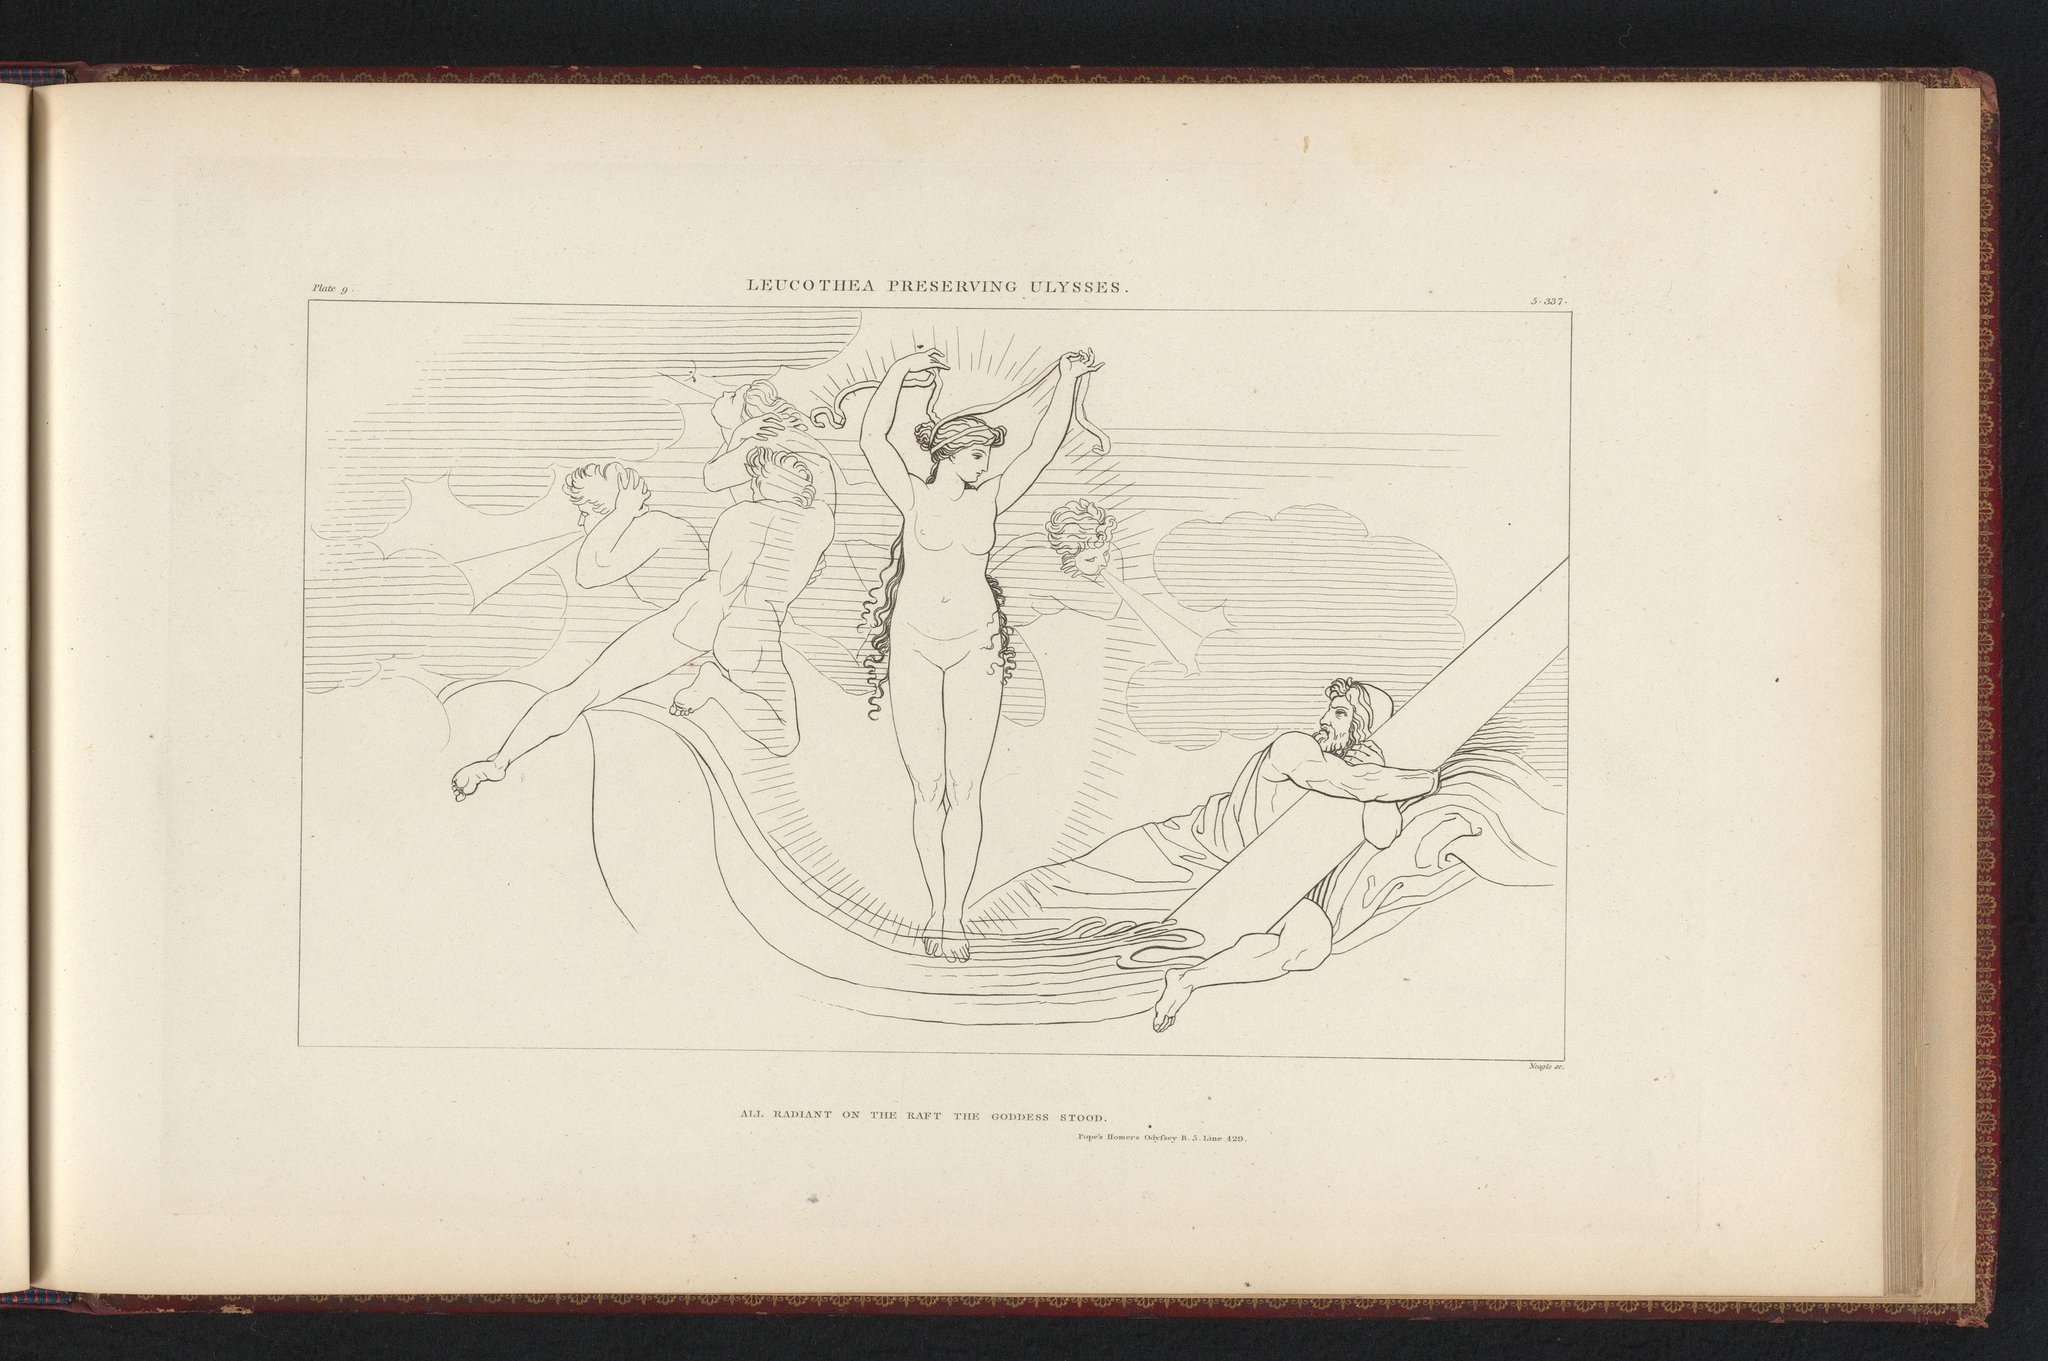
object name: print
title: Leucothea geeft Odysseus een sjaal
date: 1805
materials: paper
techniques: etching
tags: leucothea, in the guise of a sea-gull, gives ulysses a scarf to wind around his waist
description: Prent maakt onderdeel uit van een serie met 34 prenten over de Odyssee, geschreven door Homerus.